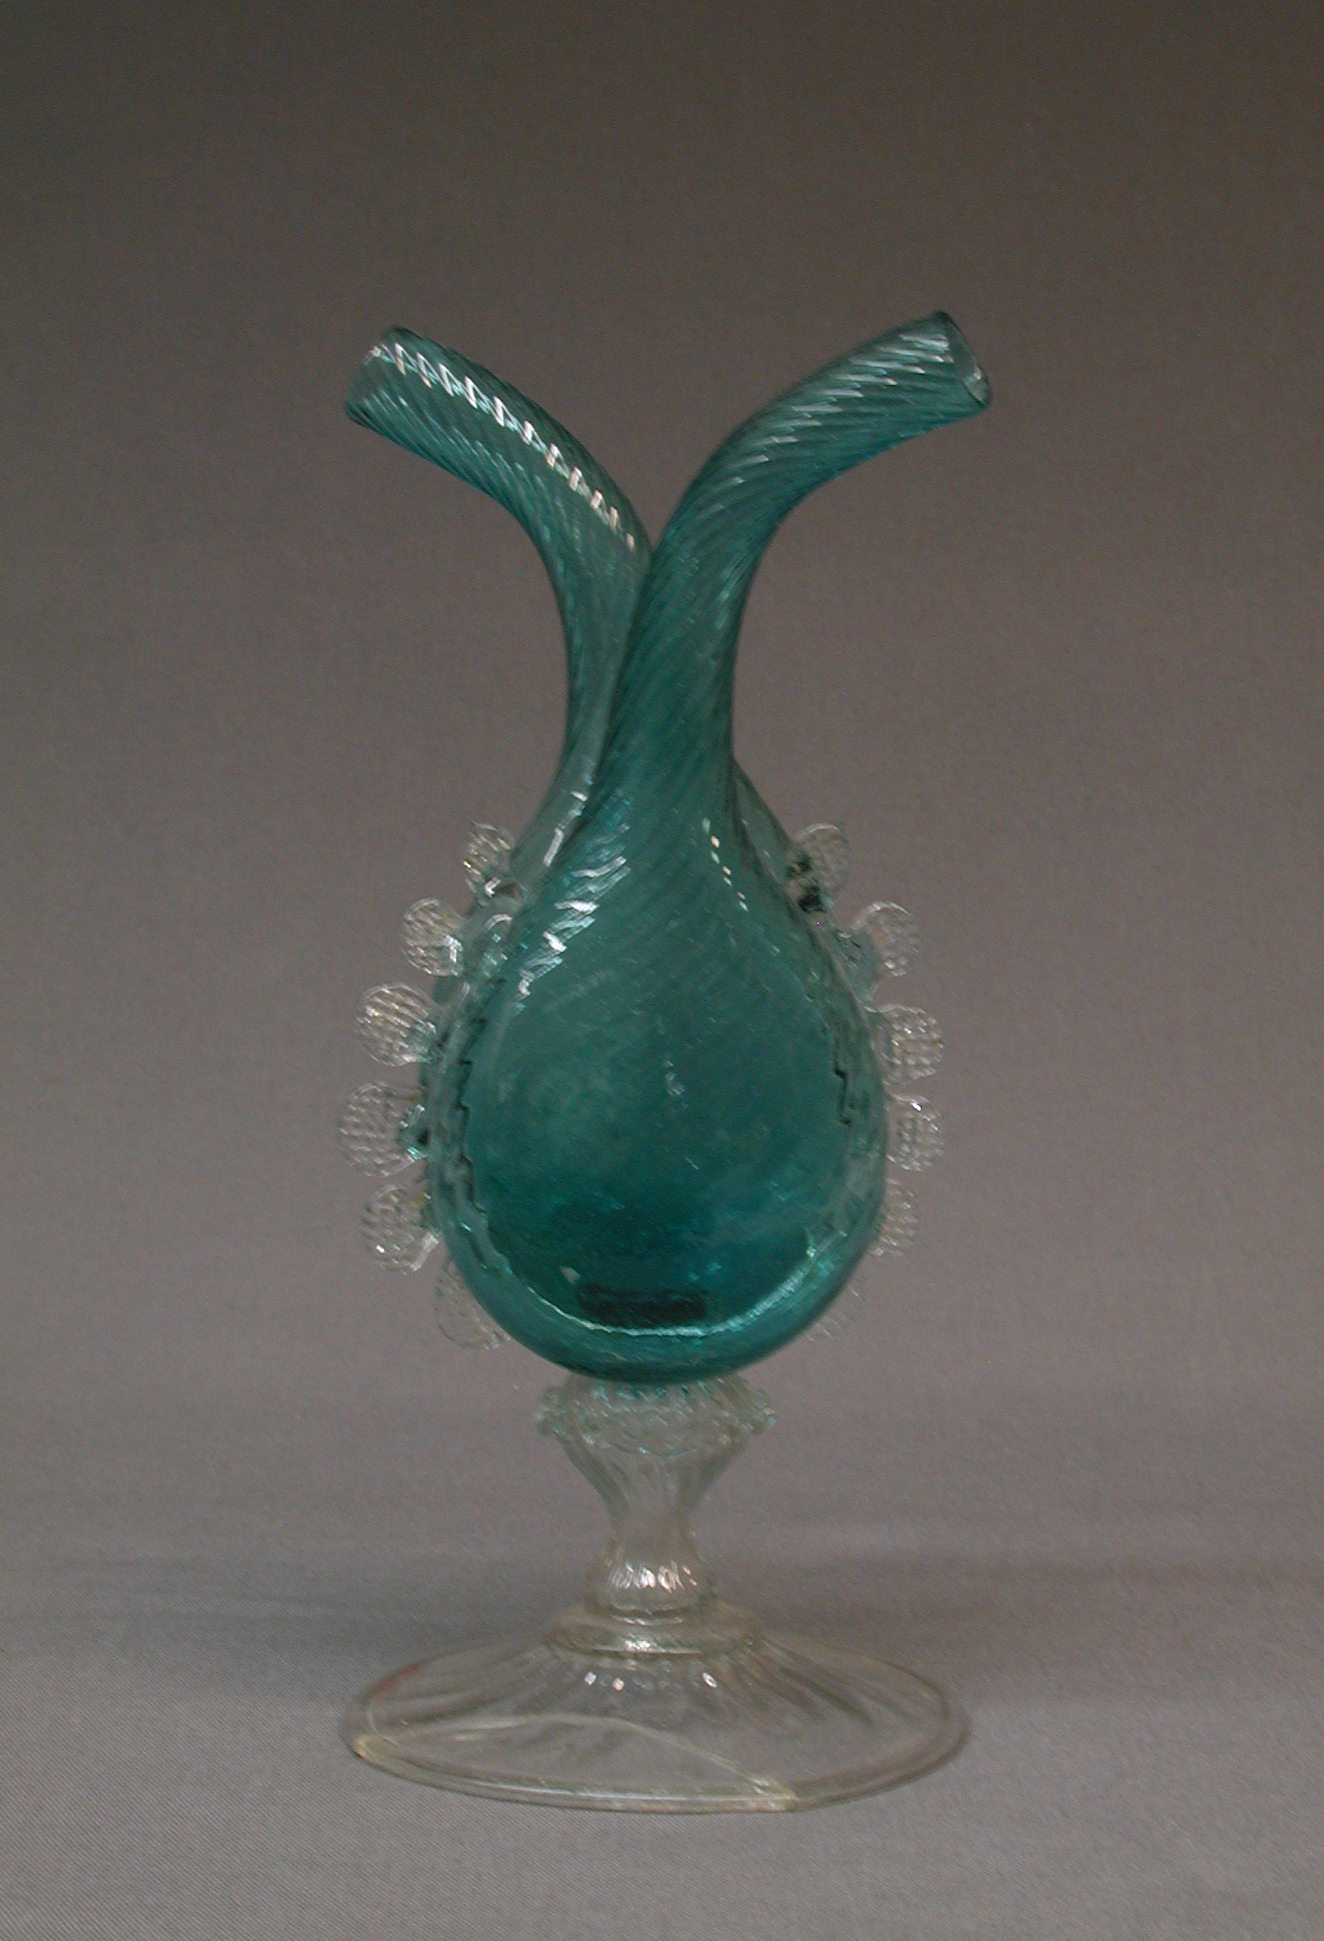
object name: double flask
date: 1801-1900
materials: glass